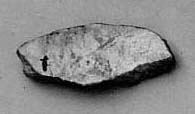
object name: fragment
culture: burmese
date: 1902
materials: jade